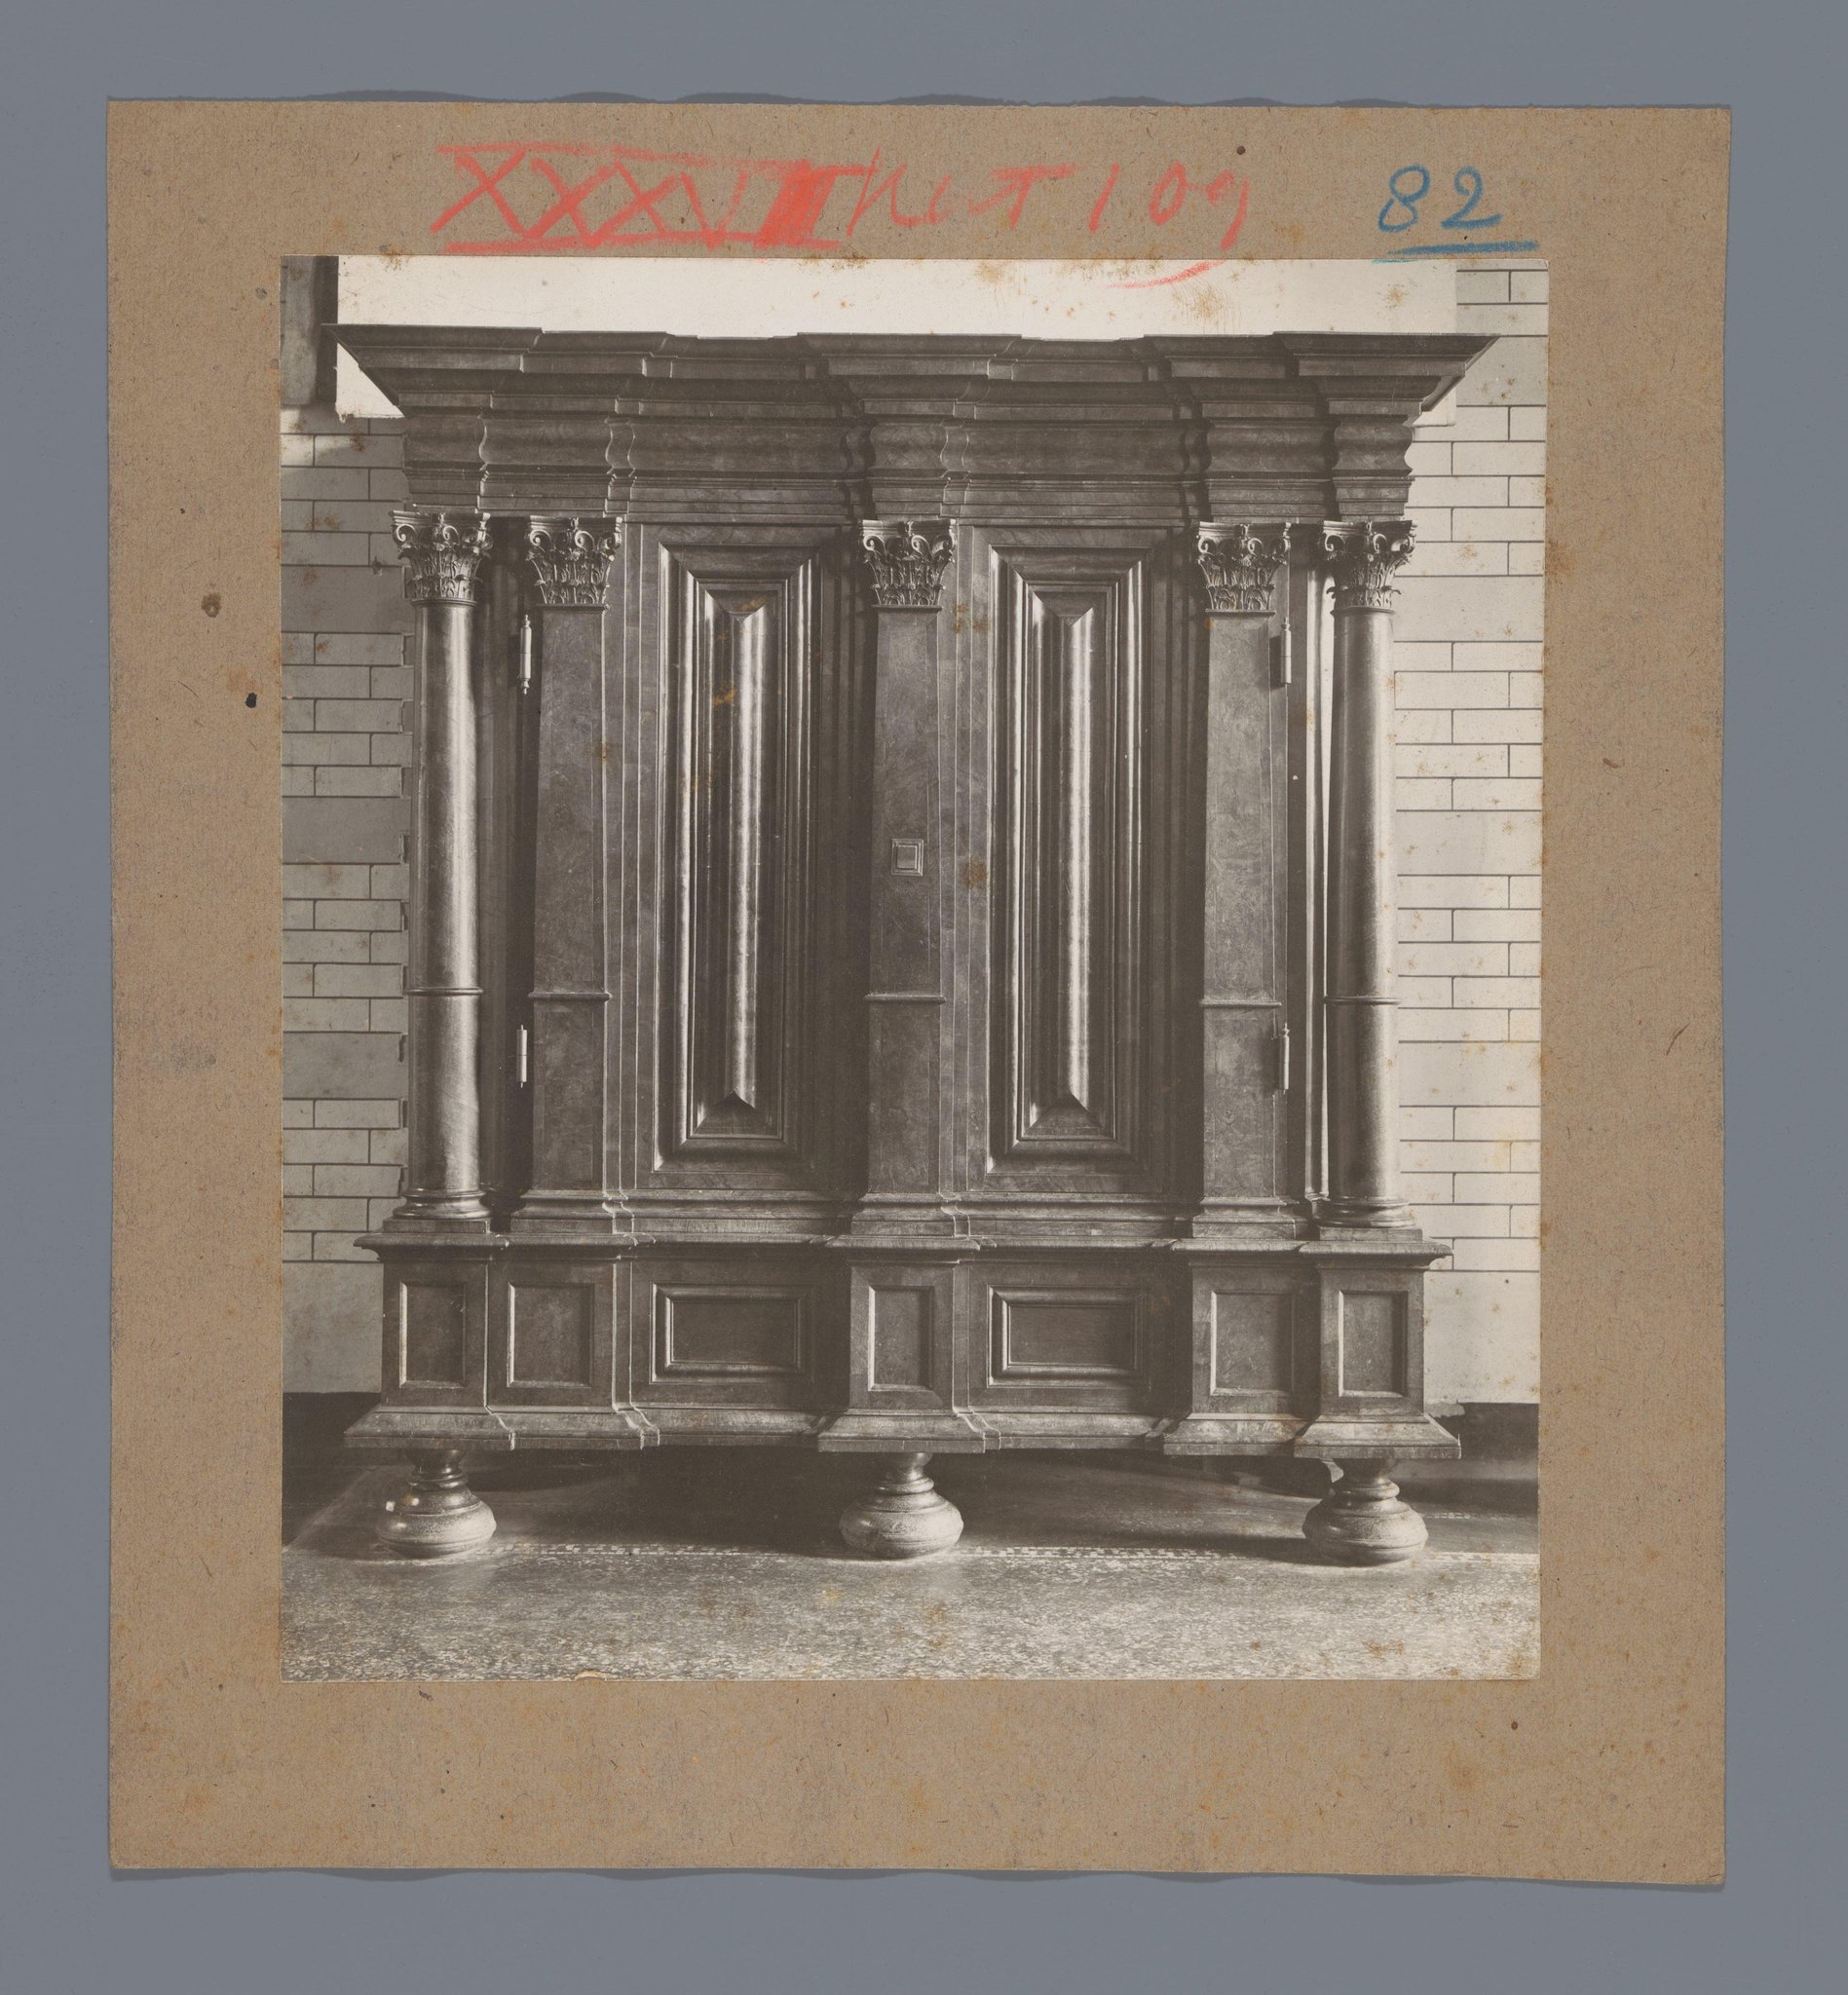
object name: photograph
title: Kussenkast met zuilen (vermoedelijk) in het Rijksmuseum te Amsterdam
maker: Anonymous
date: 1875-1900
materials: paper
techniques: carbon print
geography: amsterdam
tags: wardrobe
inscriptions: collector's mark: ‘Kunstnijverheidschool Quellinus Amsterdam Frans Halsstraat 14.’, collector's mark: ‘Instituut voor kunst-nijverheidsonderwijs Gabriël Metsustraat No. 16, Amsterdam’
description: Voor een andere foto van dezelfde kast zie RP-F-00-8445.